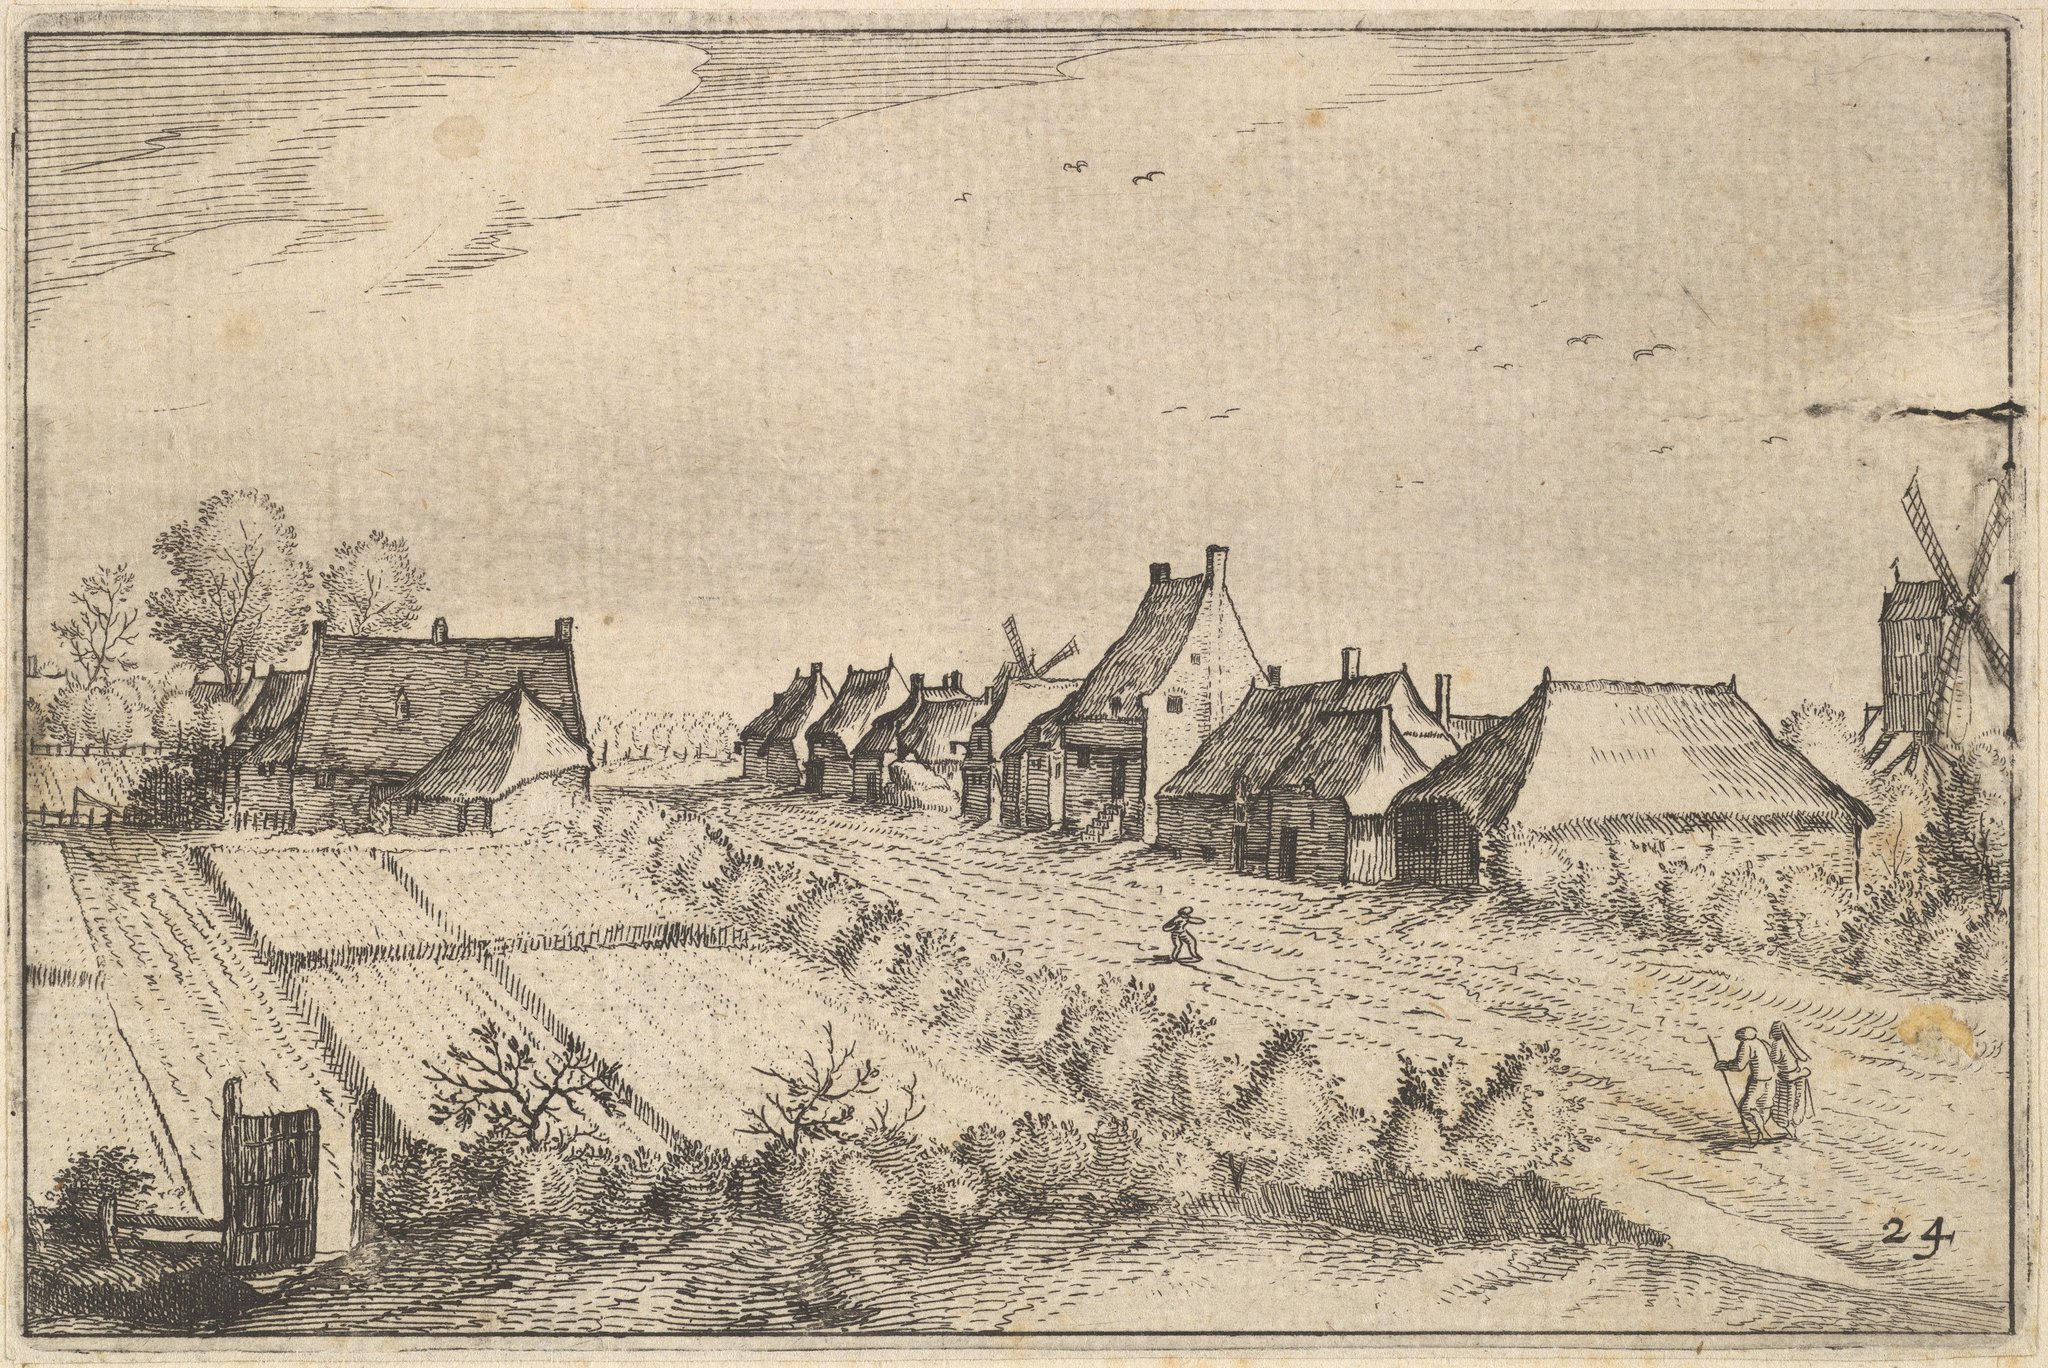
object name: print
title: Fields and a Road, plate 8 from "Regiunculae et Villae Aliquot Ducatus Brabantiae"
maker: claes jansz. visscher (ii)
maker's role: artist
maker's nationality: dutch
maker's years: 1586-1652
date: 1610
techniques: etching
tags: human figures,houses,windmills,roads,villages